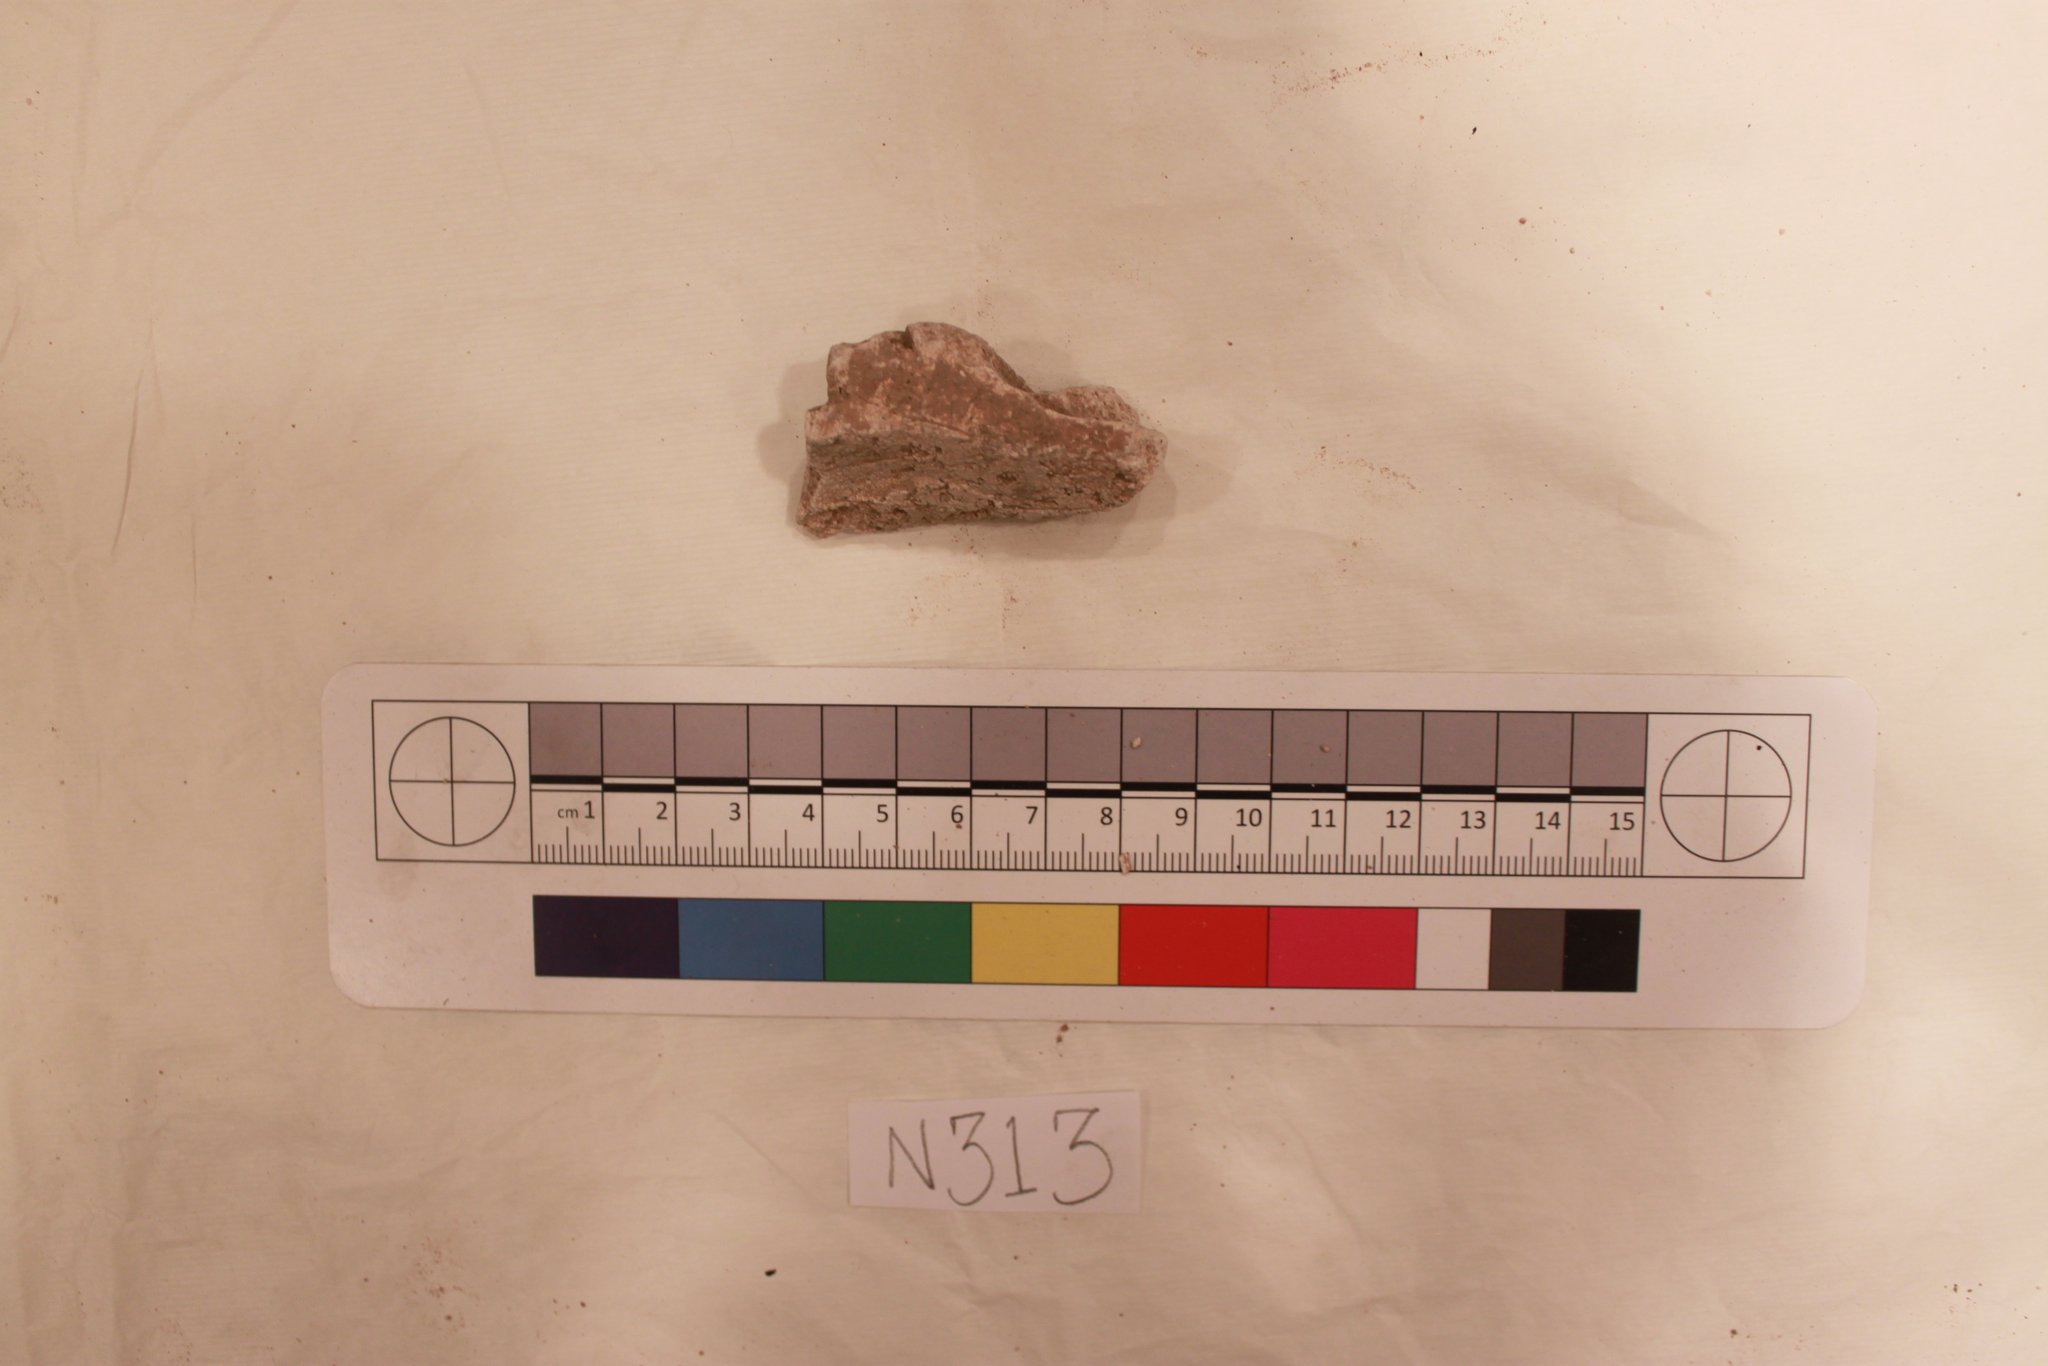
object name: fragment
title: Stucco Fragment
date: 701-1200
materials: plaster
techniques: carving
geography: iran